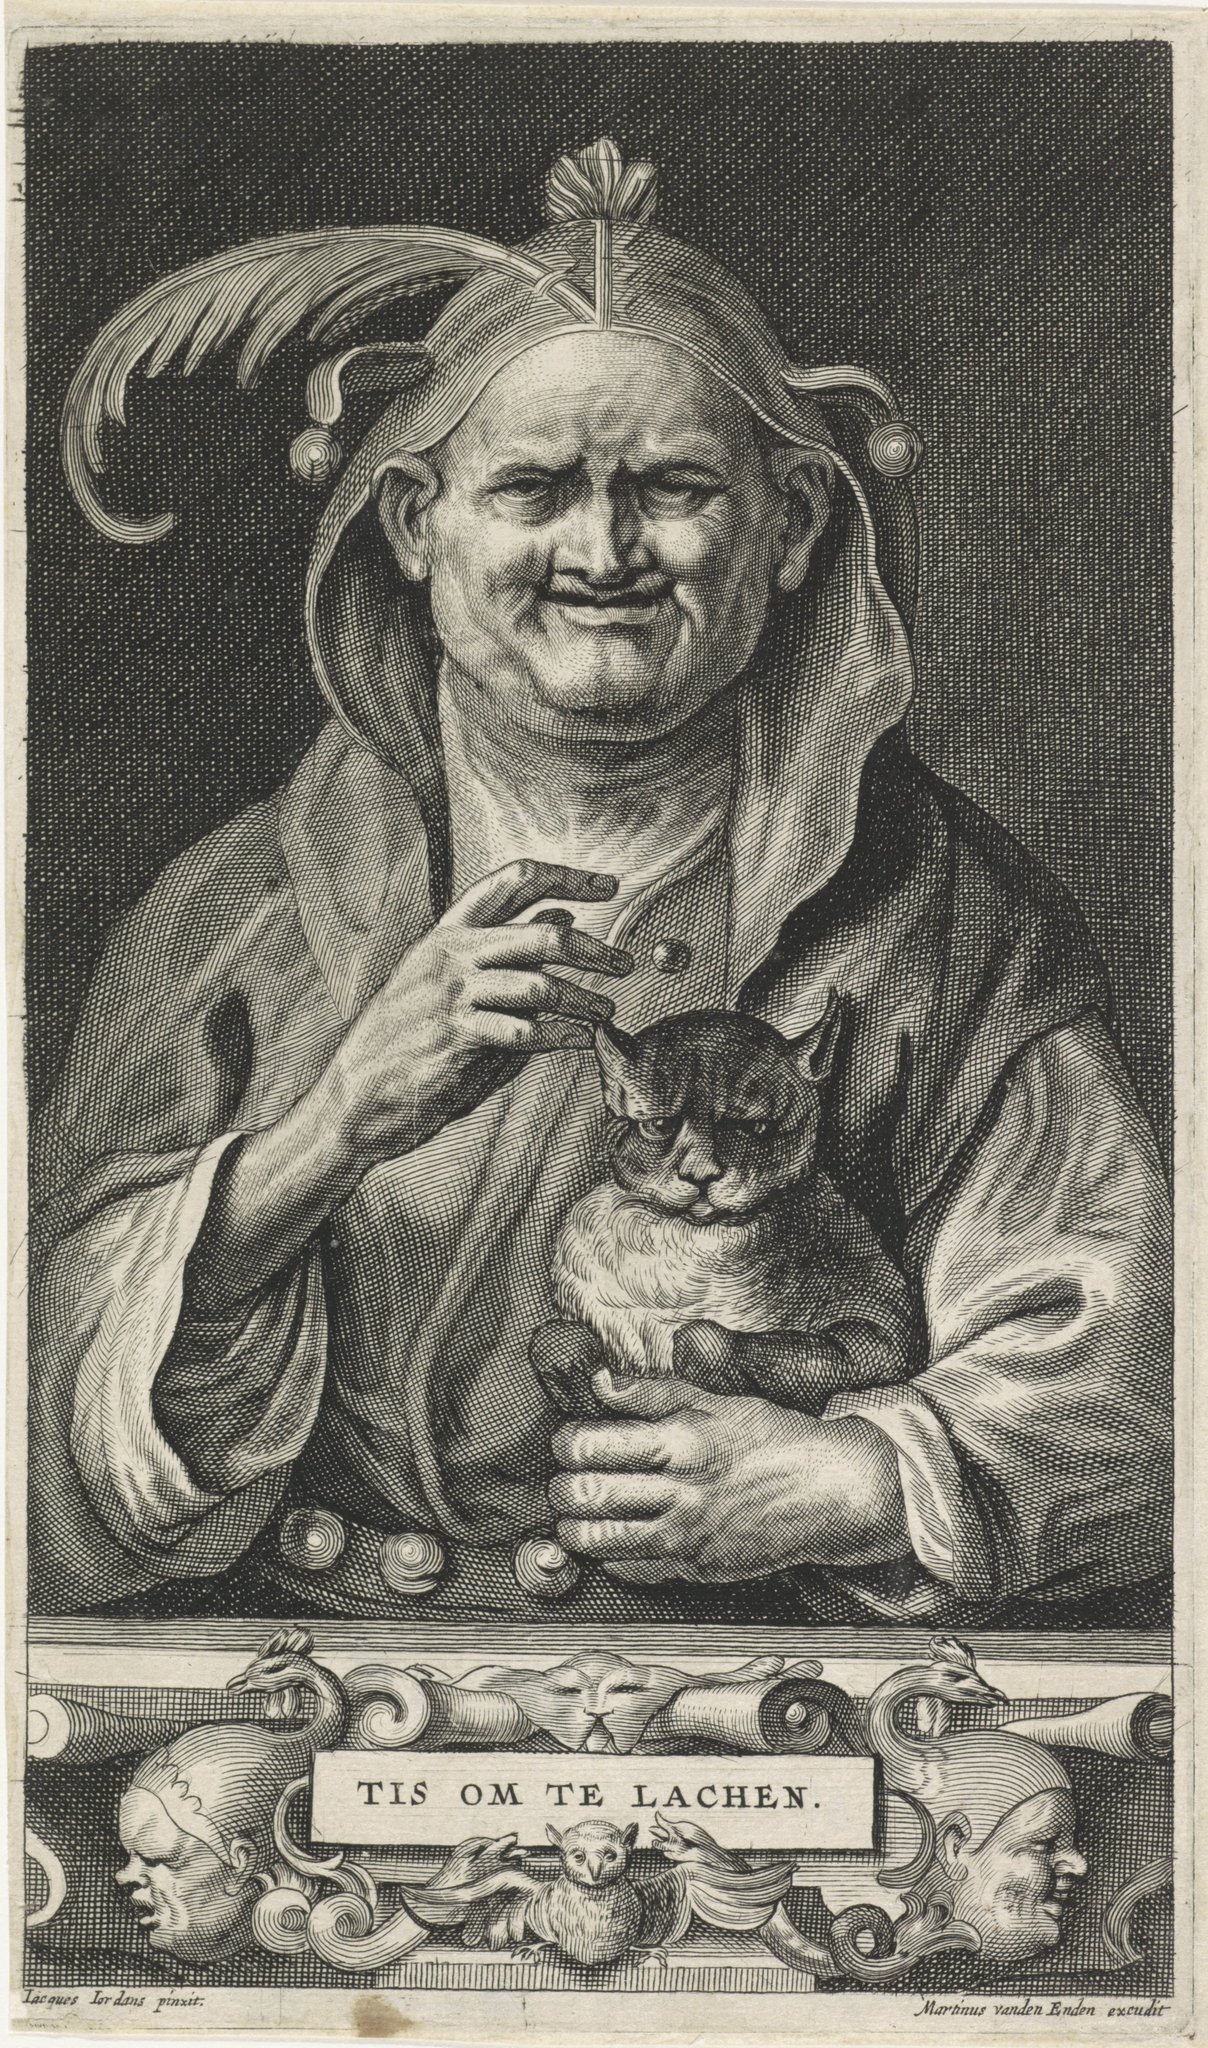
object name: print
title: Tis om te lachen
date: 1662-1674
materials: paper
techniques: engraving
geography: antwerp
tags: buffoon (in general) (german: 'schalksnarr'), cat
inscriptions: collector's mark: Lugt 240